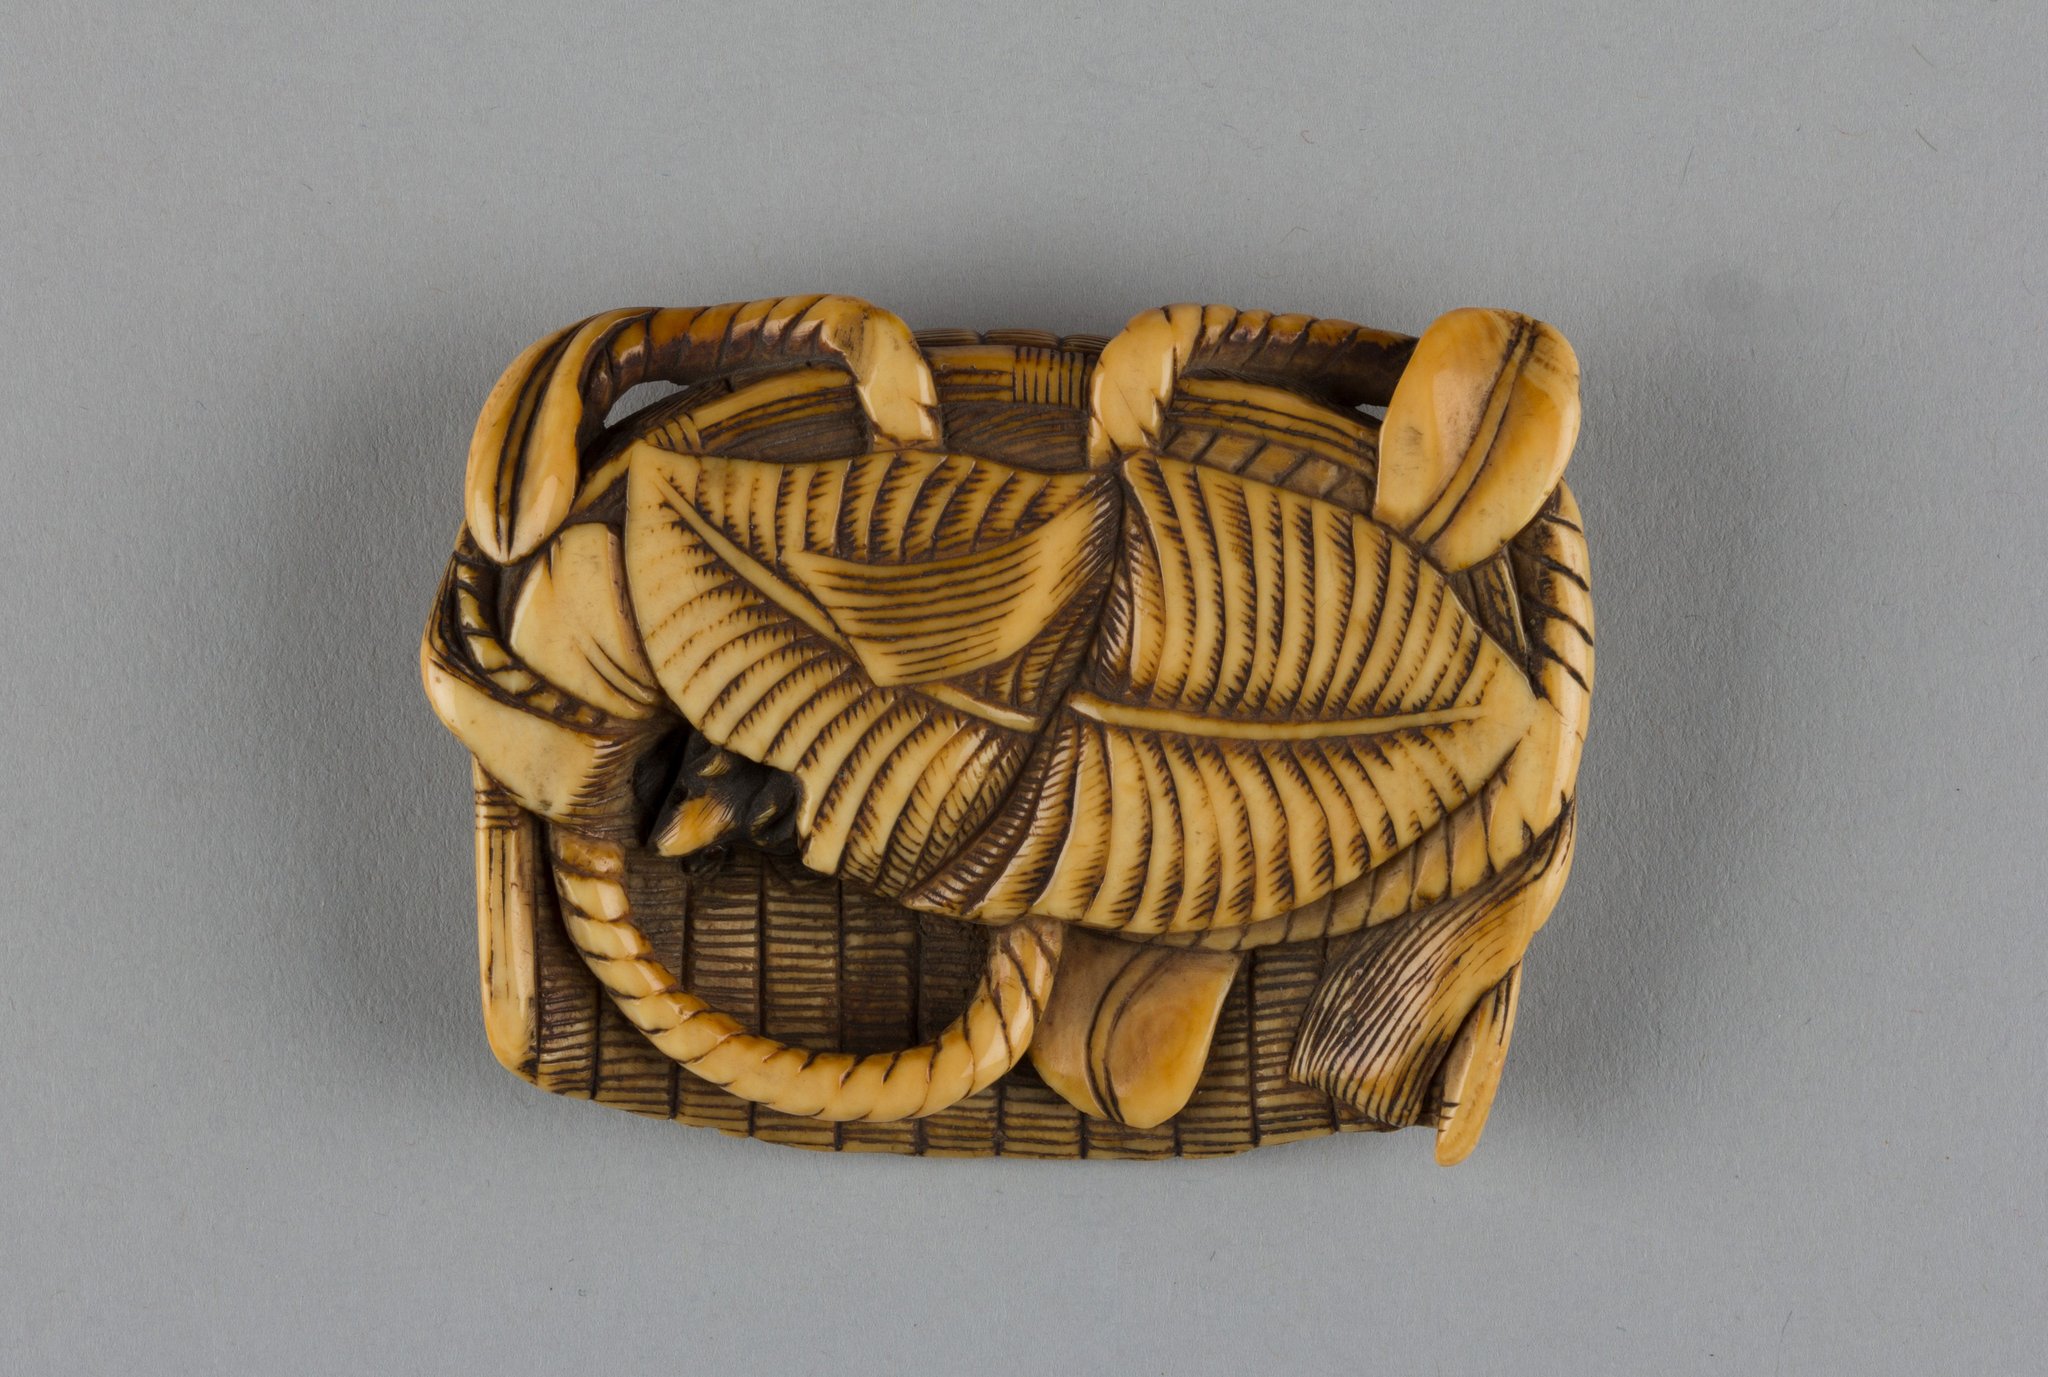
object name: netsuke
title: Netsuke of Flat Basket Containing Leaves and a Mouse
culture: japanese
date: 1801-1900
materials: ivory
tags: mice